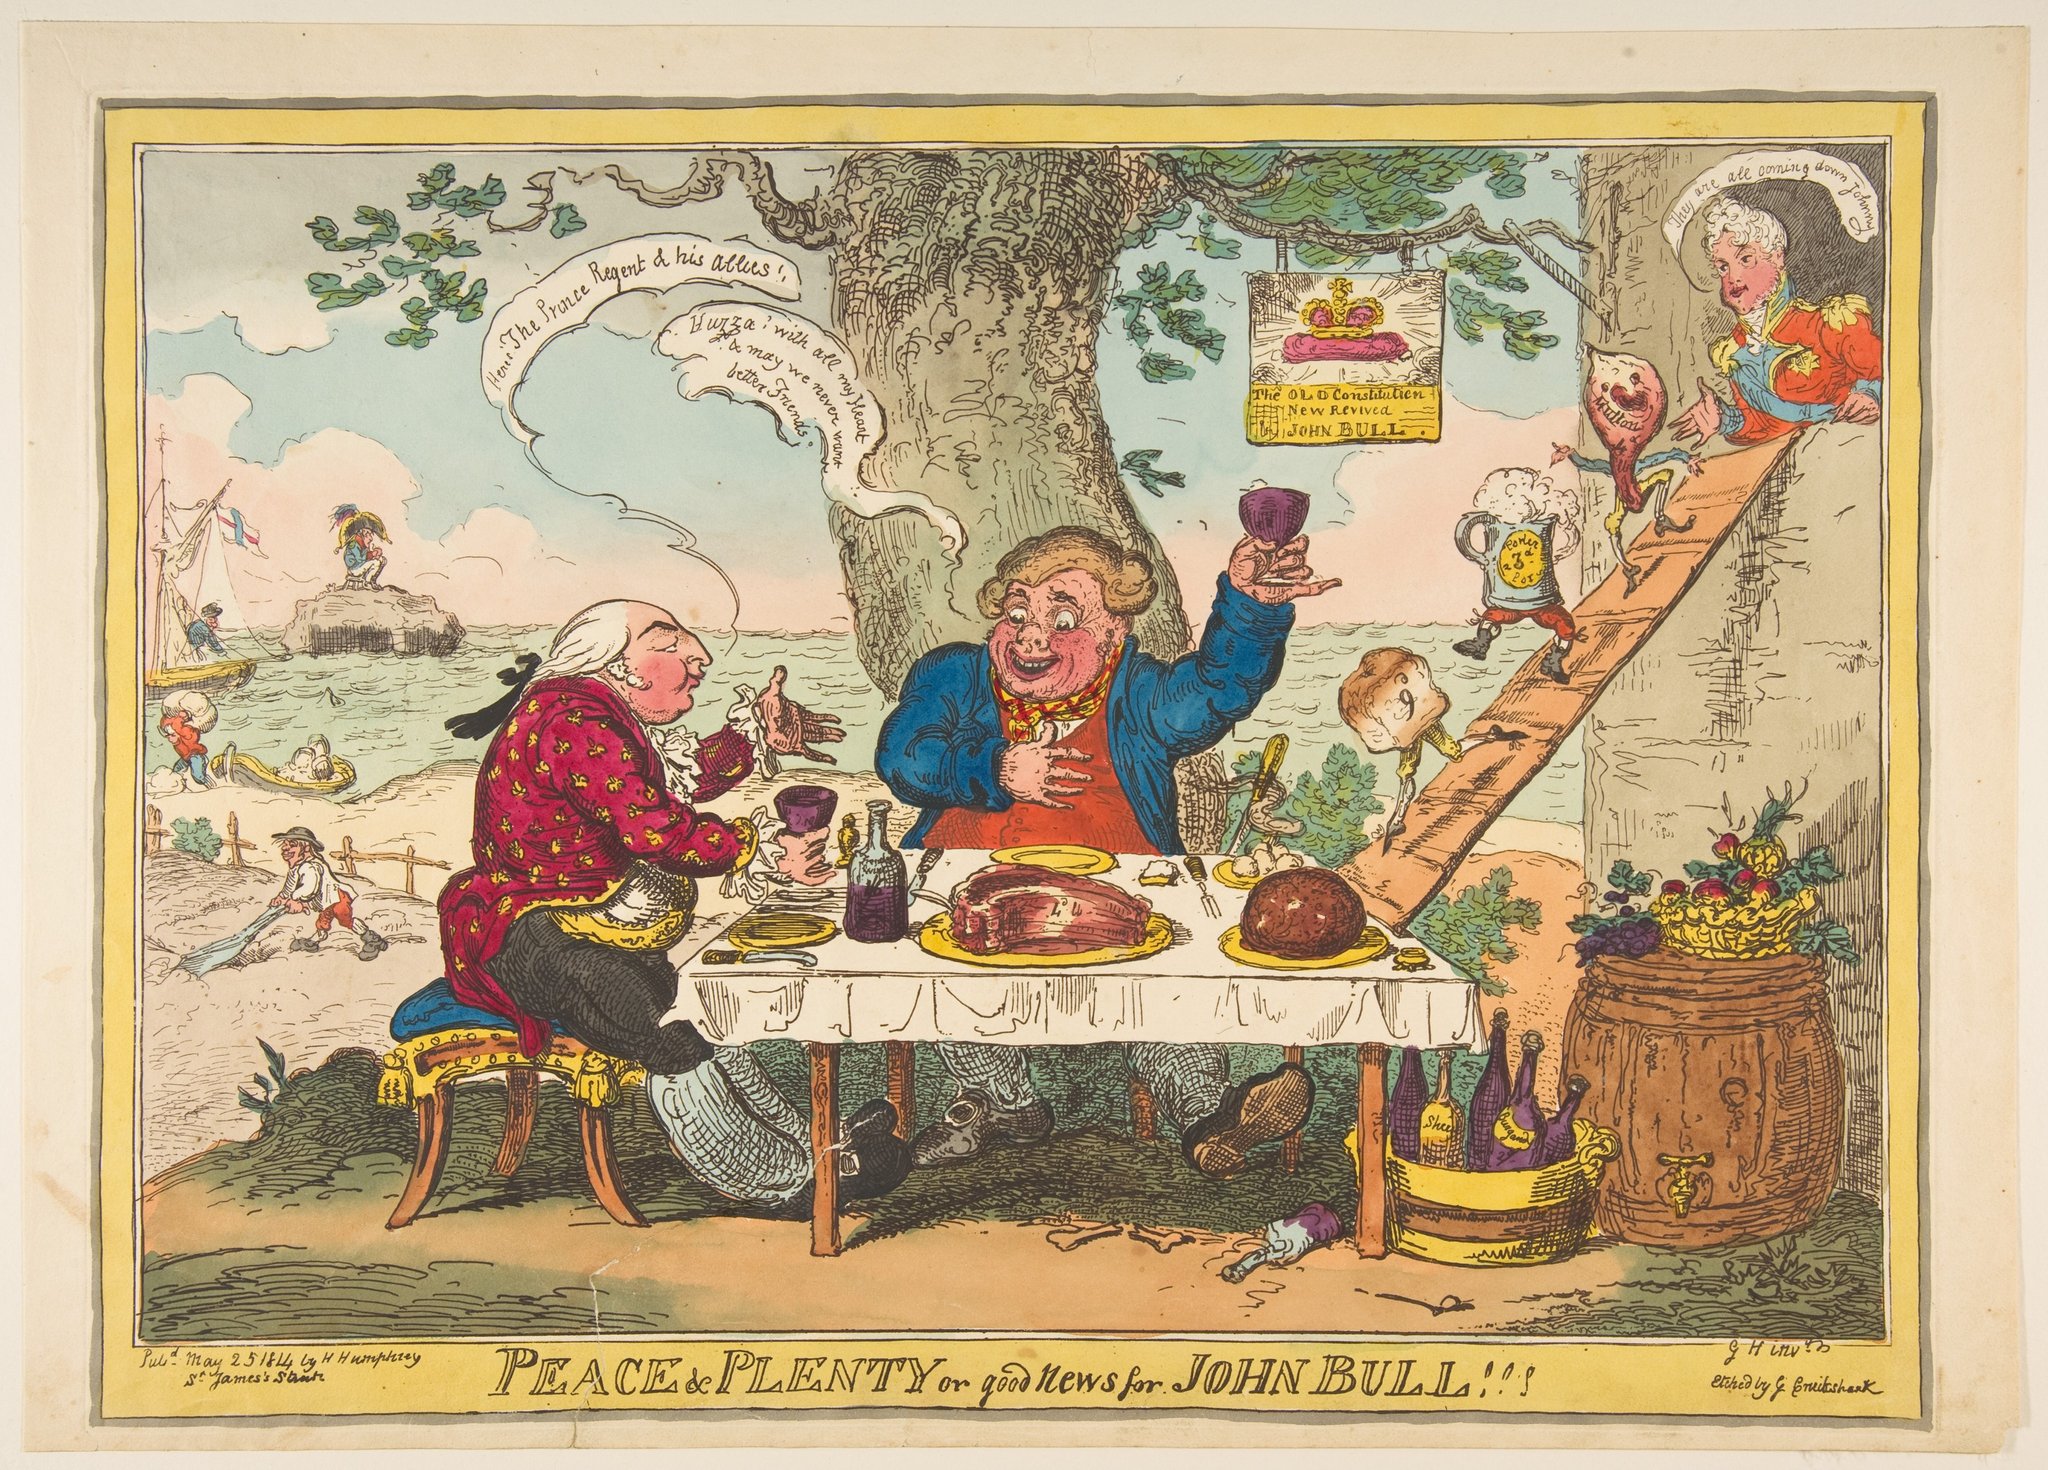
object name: print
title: Peace and Plenty or Good News for John Bull!!!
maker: george cruikshank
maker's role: artist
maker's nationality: british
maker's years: 1792-1878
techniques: etching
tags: food,satire,men,dining,drinking,tables